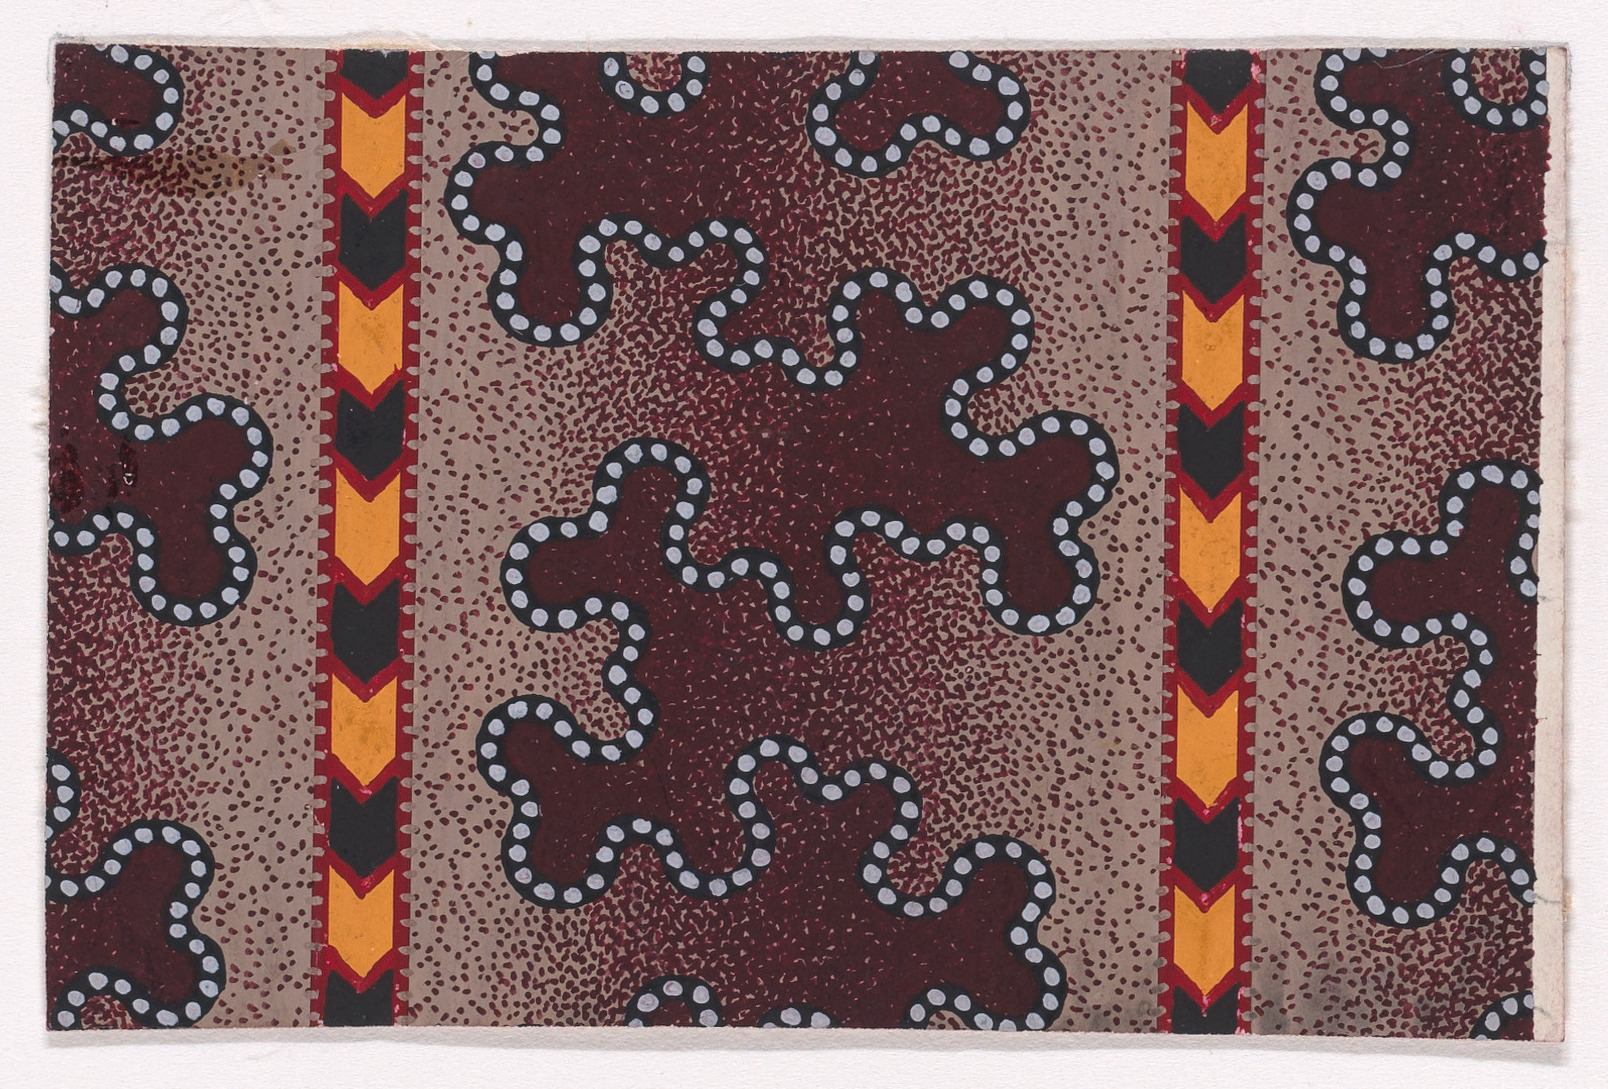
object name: drawing ornament architecture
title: Textile Design with Alternating Quatrefoils Bordered with Pearls and Framed by Interlacing Ribbons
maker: anonymous, alsatian, 19th century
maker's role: artist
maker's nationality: alsatian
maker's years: 1800-1900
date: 1840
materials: gouache